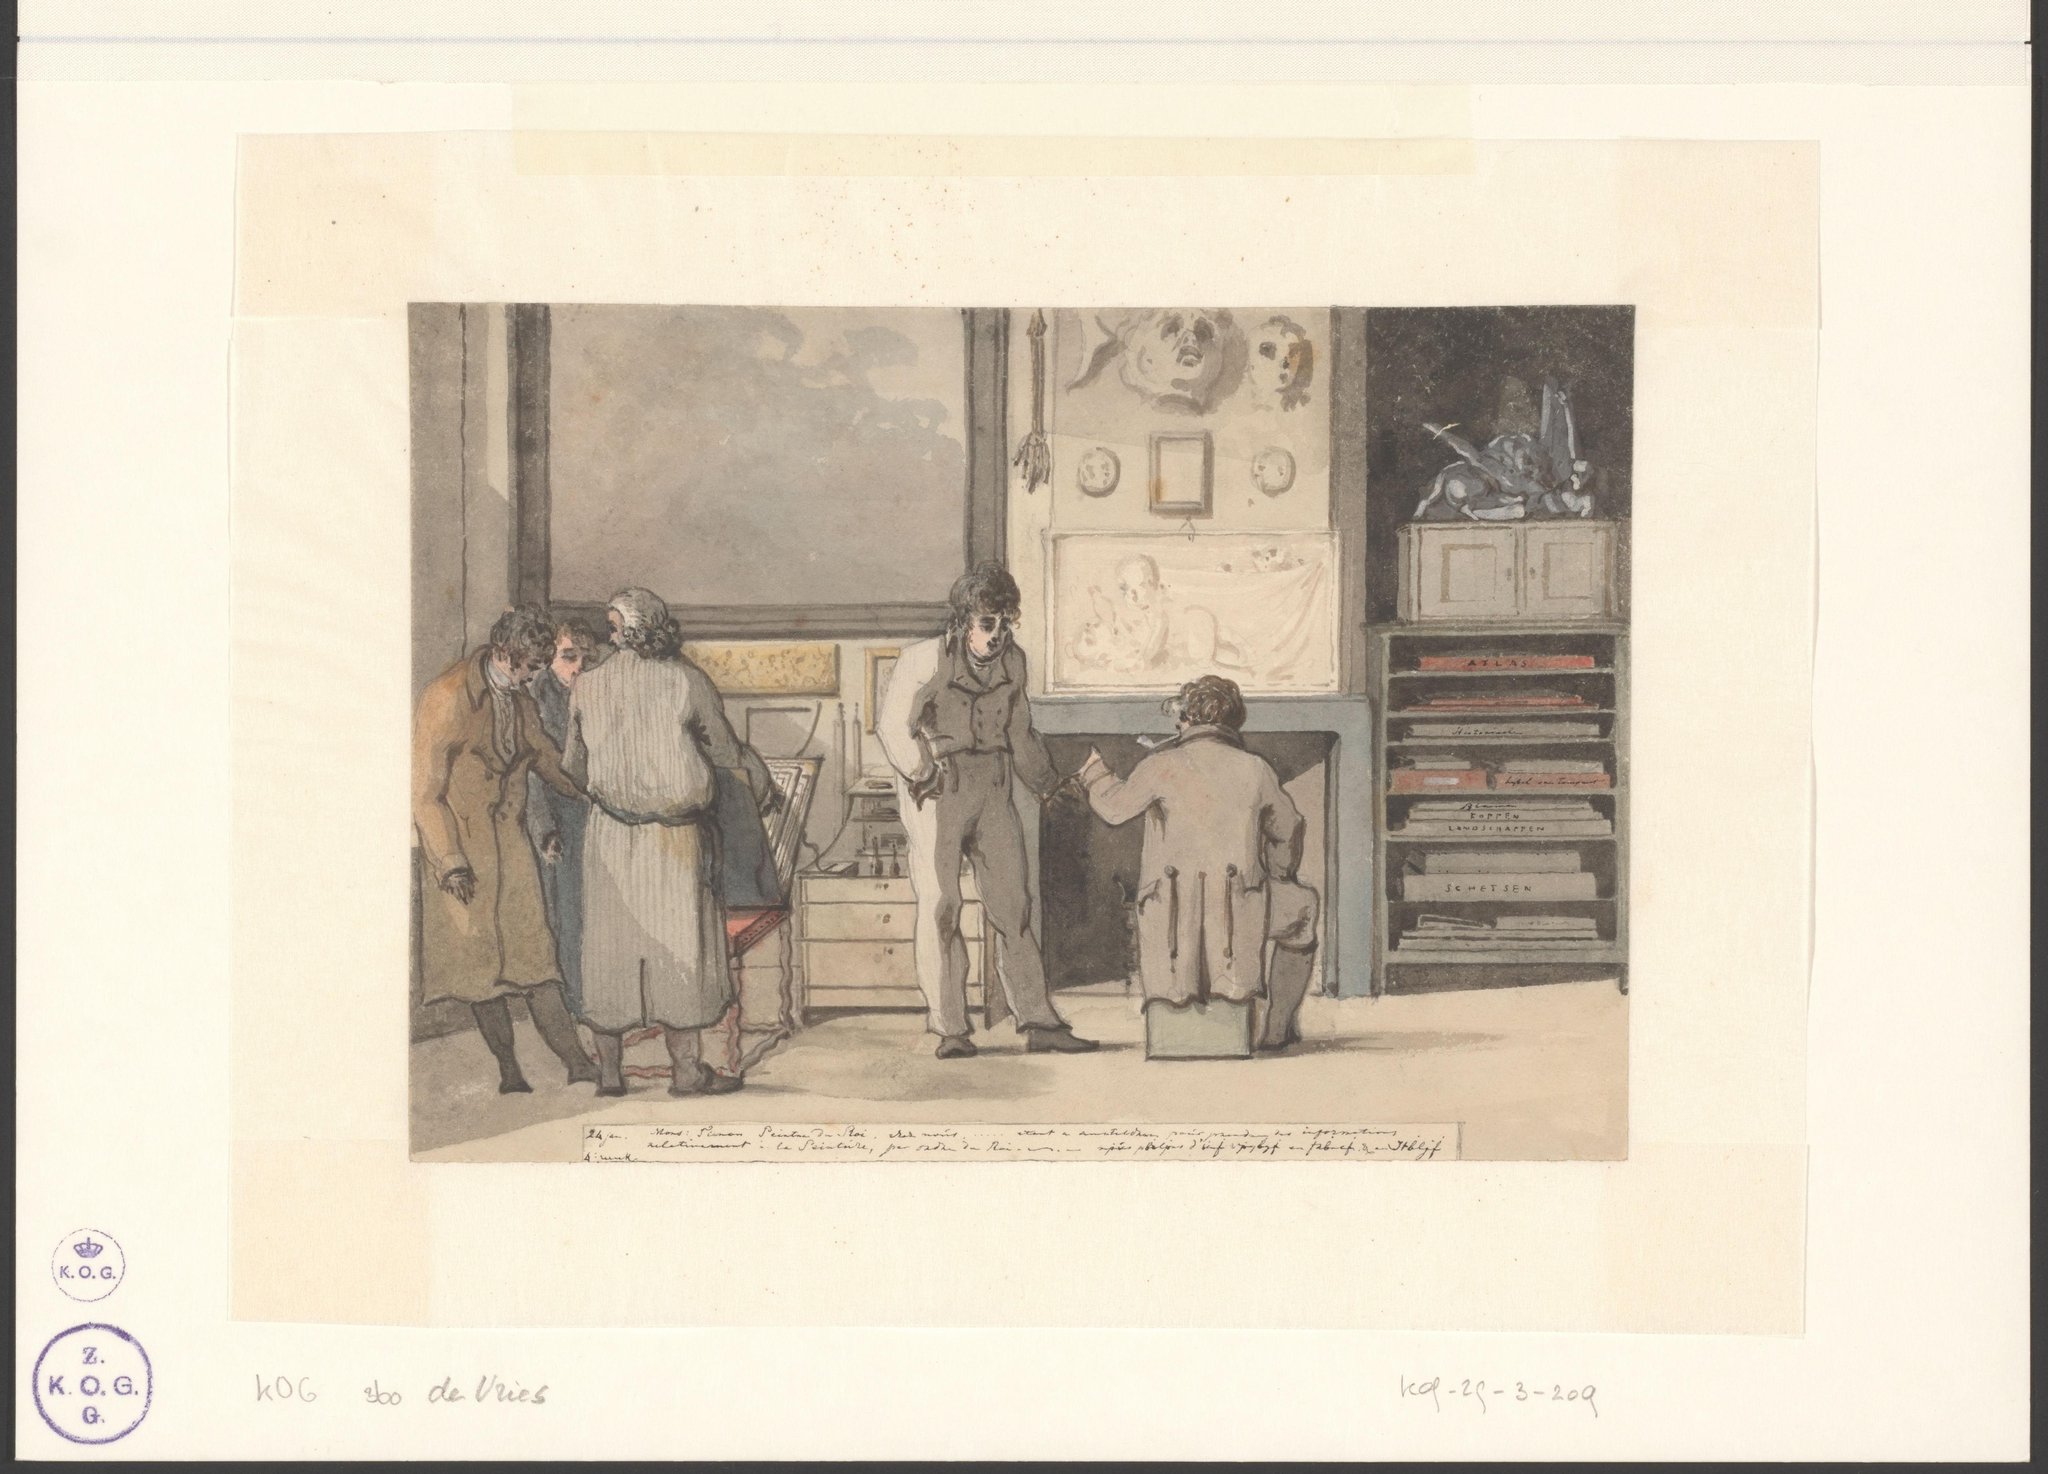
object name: drawing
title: Claude Thiénon op bezoek bij de familie Andriessen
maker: christiaan andriessen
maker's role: draughtsman, print maker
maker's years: 1775-1846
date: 1807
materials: ink, paper, pencil, watercolor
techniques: brush, pen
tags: amsterdam, print maker, draughtsman, christiaan andriessen, painter, jurriaan andriessen, paris, claude thiénon, artist at work, in his workshop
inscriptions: signature: ‘J Andriessen’, inscription:, collector's mark: Lugt 1641, collector's mark: Lugt 1641a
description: Claude Thiénon op bezoek bij de familie Andriessen. Jurriaan Andriessen toont hem een portefeuille met tekeningen.